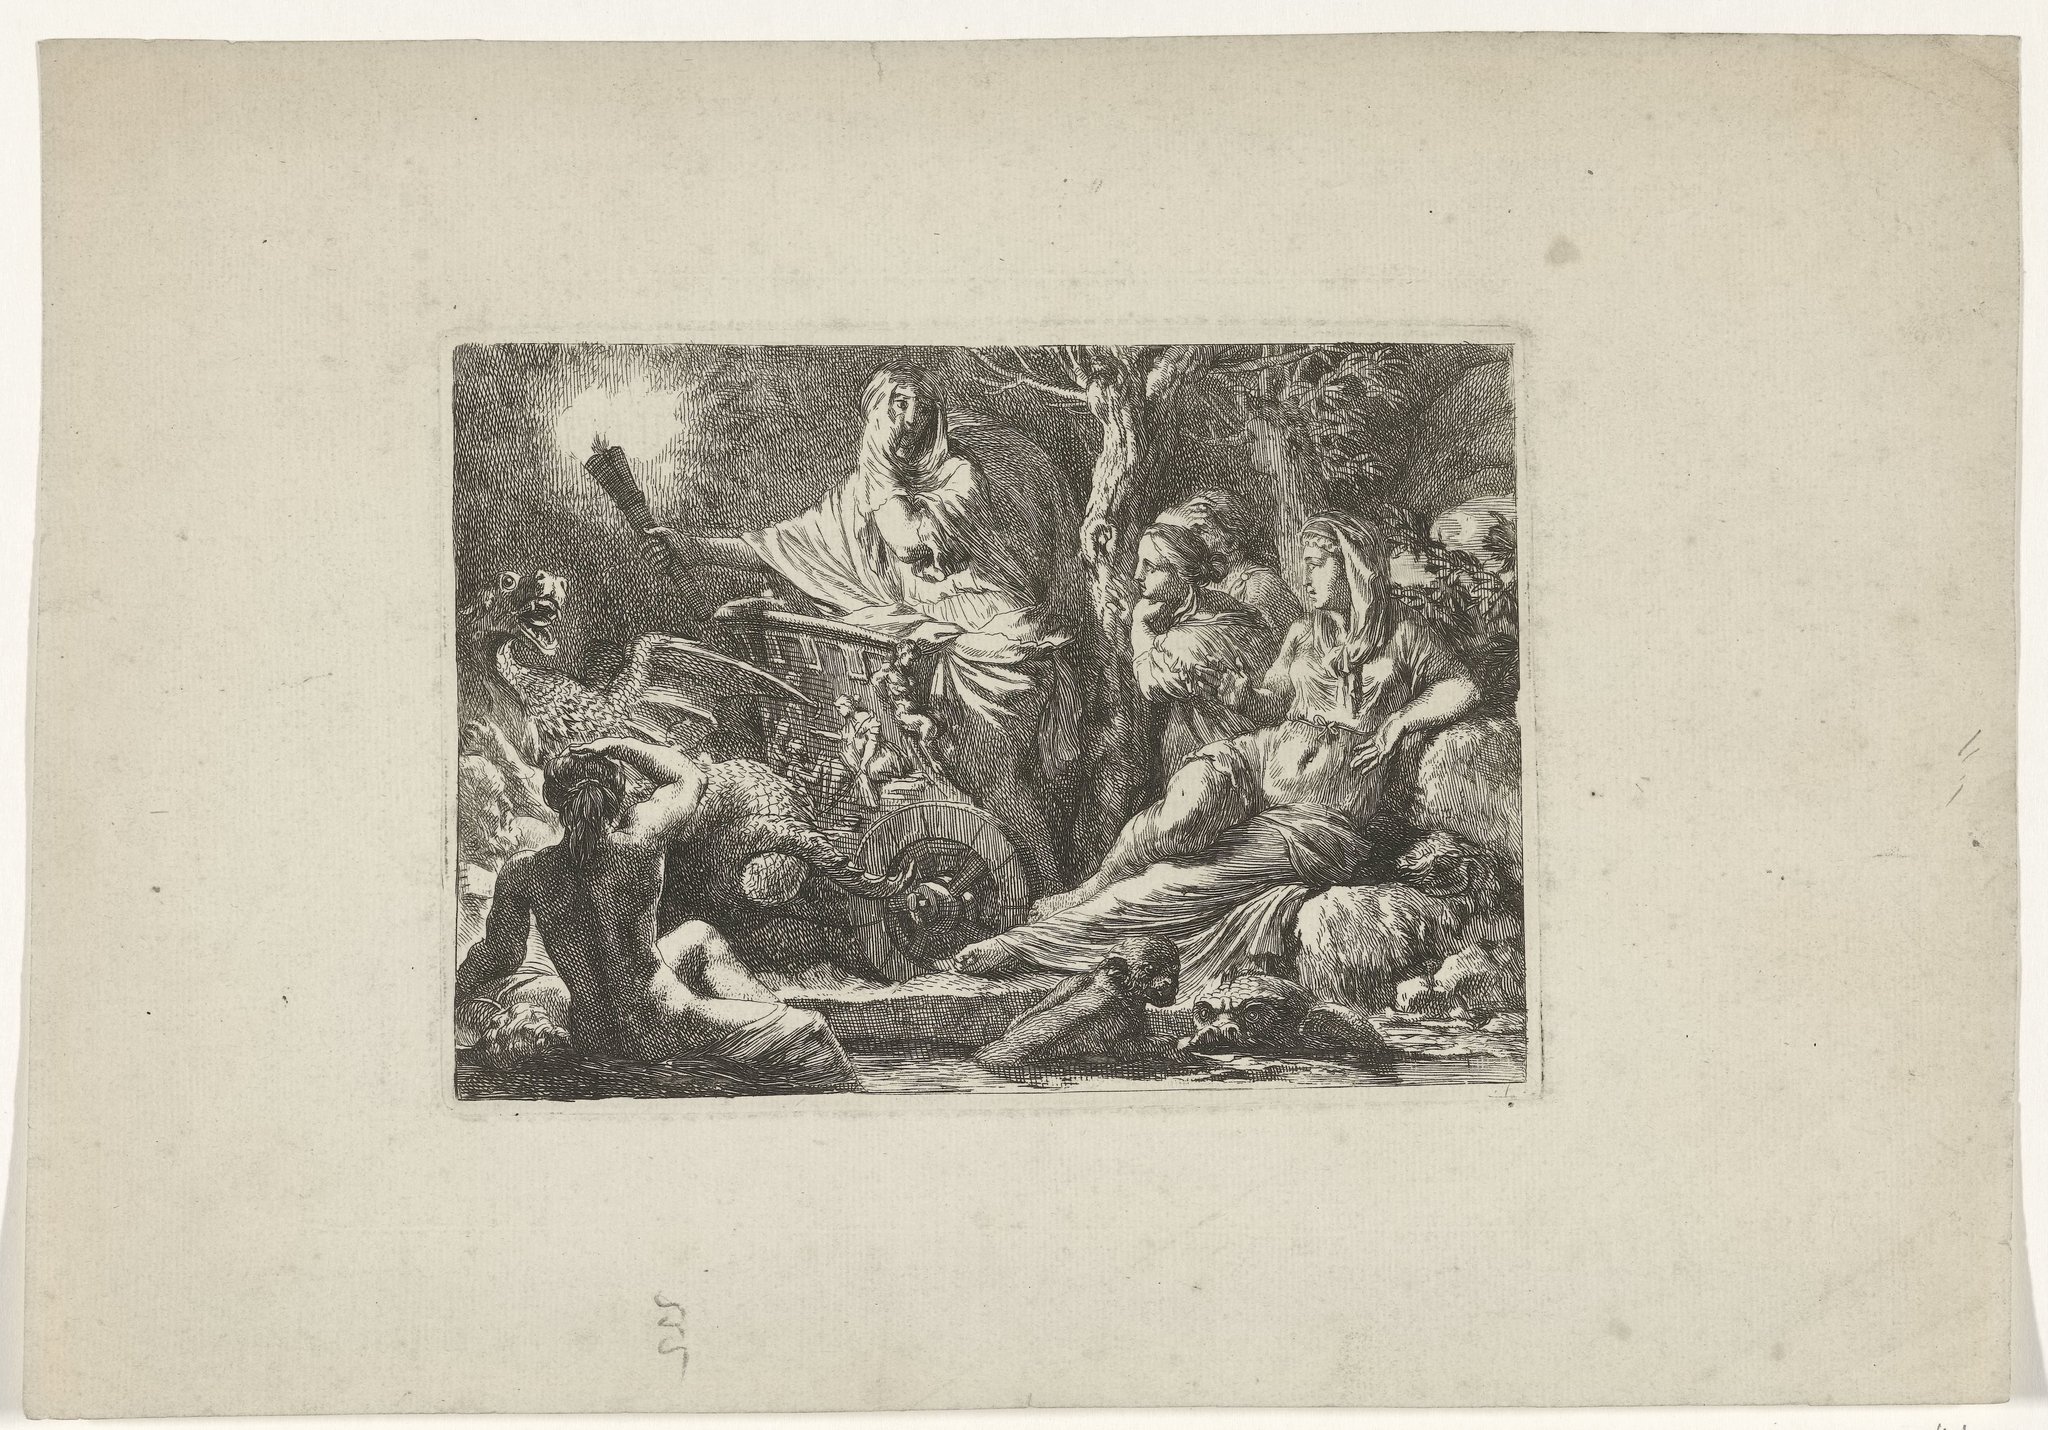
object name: print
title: Ceres op zoek naar Proserpina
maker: gerard de lairesse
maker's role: draughtsman, painter, print maker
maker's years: 1641-1711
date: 1670-1675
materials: paper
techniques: etching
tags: most important deeds: ceres in search of her daughter proserpina, whom pluto carried off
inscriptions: collector's mark: Lugt 2228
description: Ceres, godin van de landbouw, rijdt gesluierd met een toorts in haar hand op een door draken getrokken wagen. Ze is op zoek naar haar dochter Proserpina die door Pluto geroofd is. Op de voorgrond zitten vrouwen bij een beek waarin monsterachtige wezens zwemmen. Scène afkomstig uit de Metamorfosen van Ovidius (Met. 5:438-445).